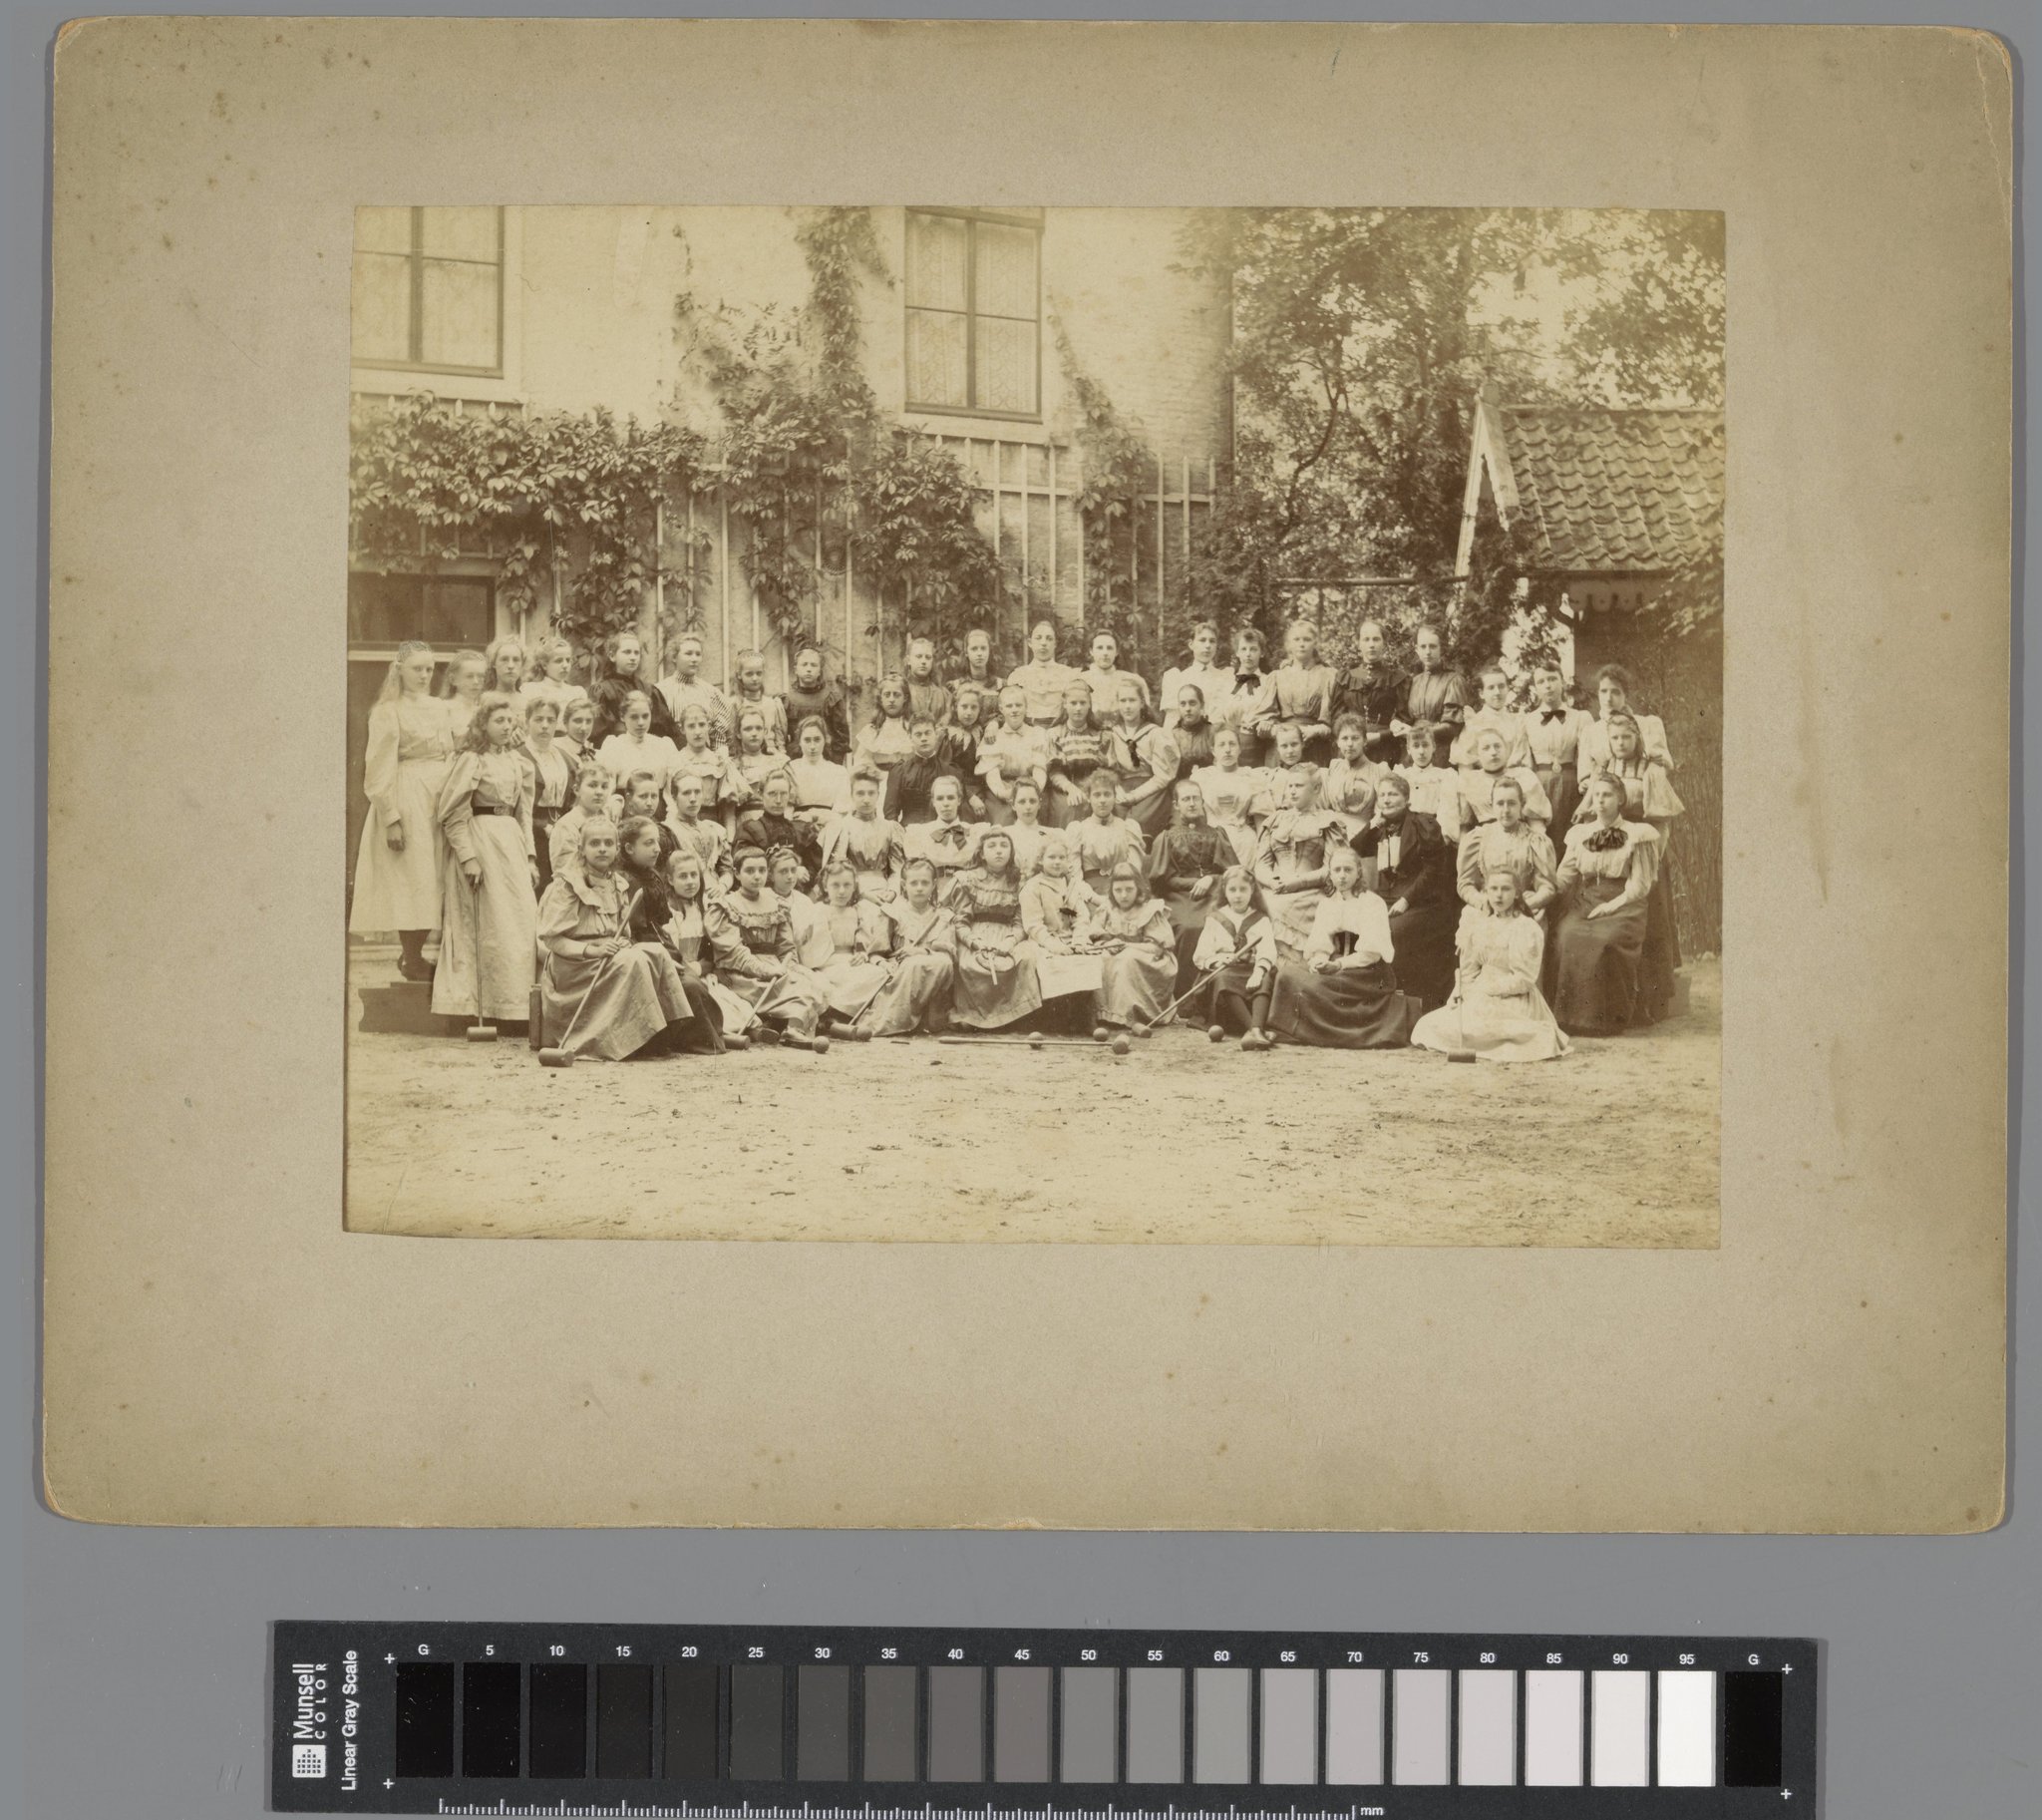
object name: photograph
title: Groepsportret meisjes met leraressen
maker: Anonymous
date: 1890-1910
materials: cardboard, photographic support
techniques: albumen print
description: De meisjes hebben croquet en rackets bij zich in een park.